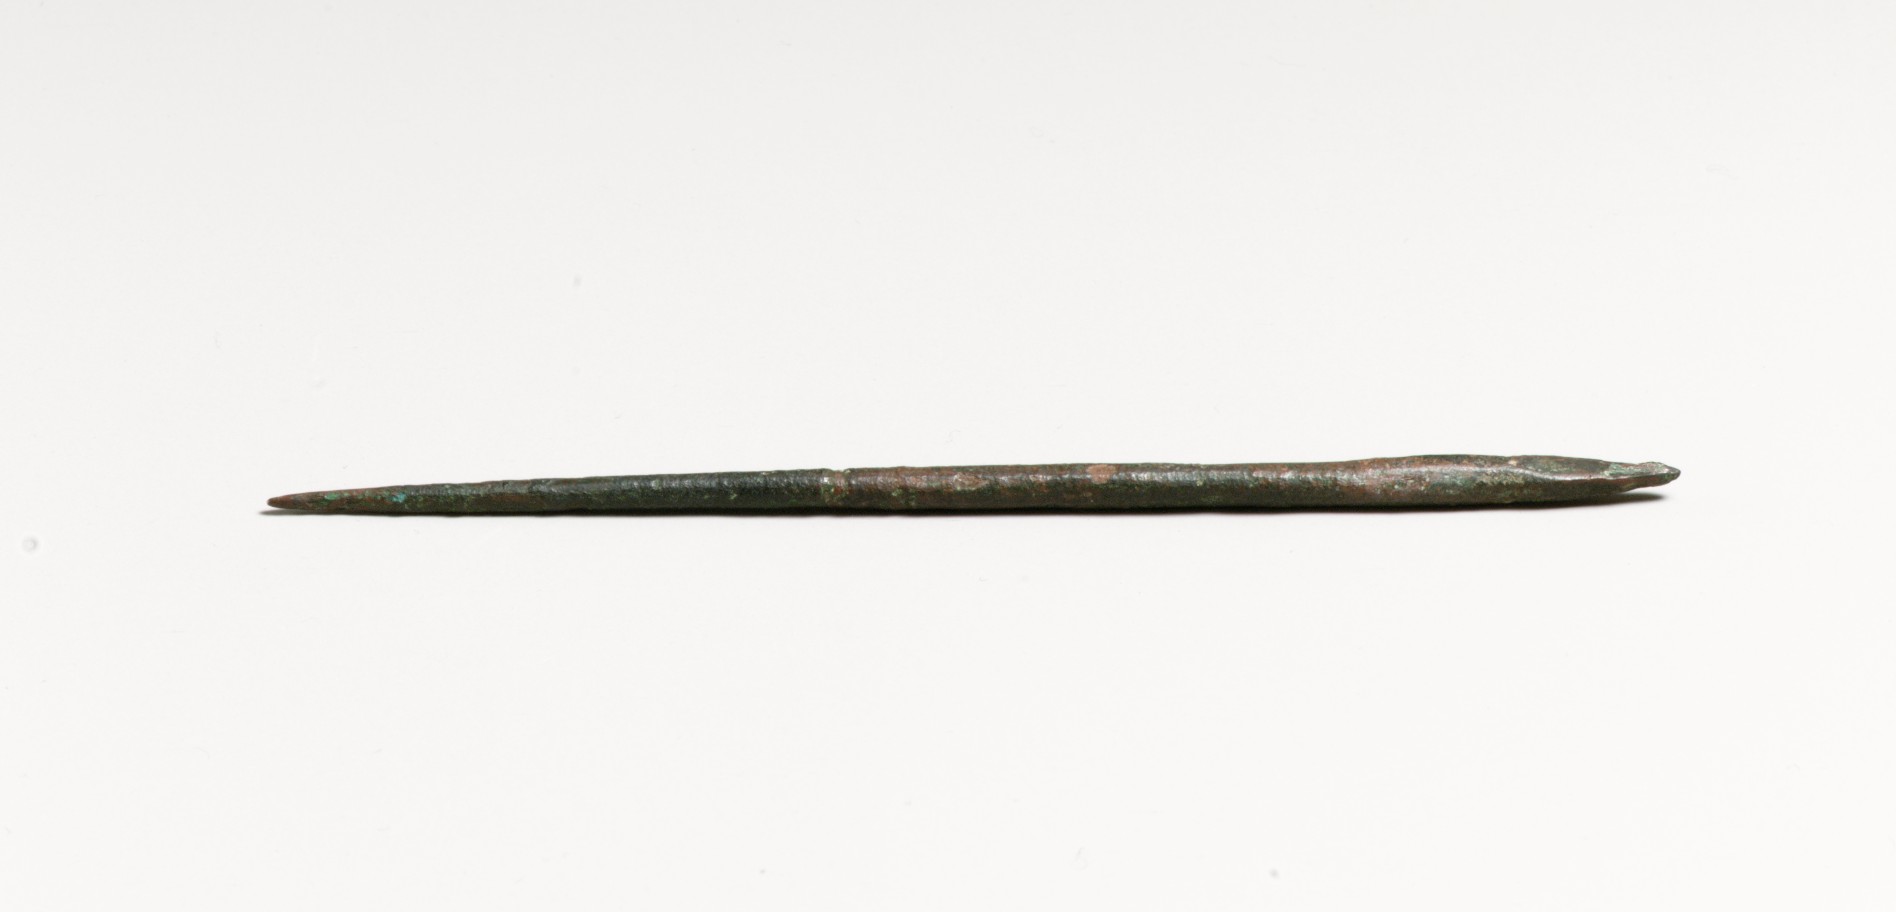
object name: awl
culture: cypriot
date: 3900 BCE-100 CE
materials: bronze